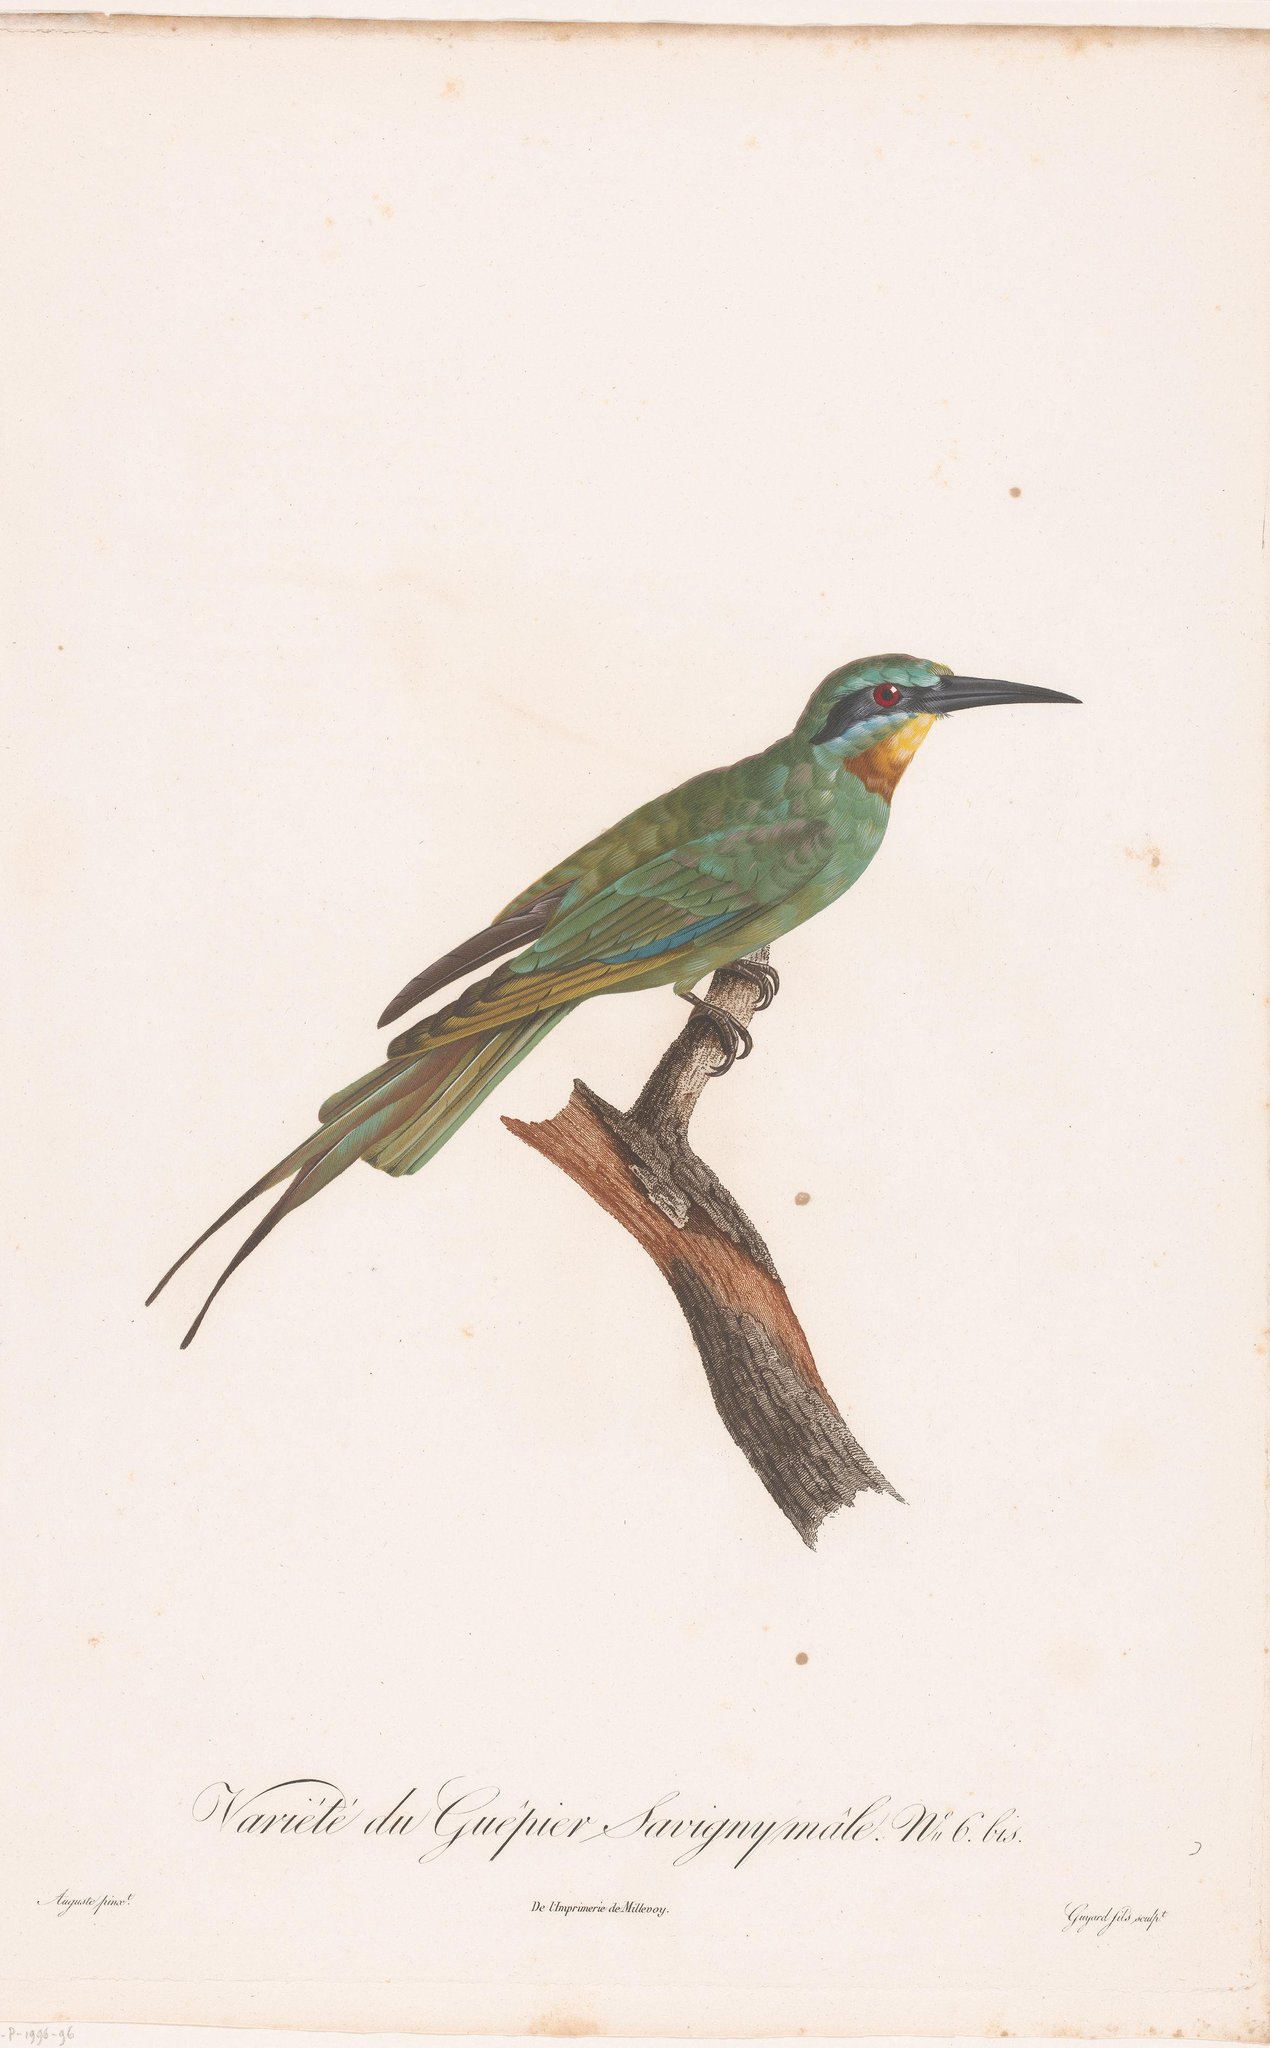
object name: print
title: Mannelijke bijeneter op een tak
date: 1801-1806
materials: paper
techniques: engraving, etching, hand coloring, lithography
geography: paris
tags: birds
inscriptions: collector's mark: Lugt 2760, collector's mark: Lugt 2228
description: Prent uit: F. Levaillant. Histoire naturelle des oiseaux de paradis. Parijs: Perlet Denné le jeune, 1801-1806.